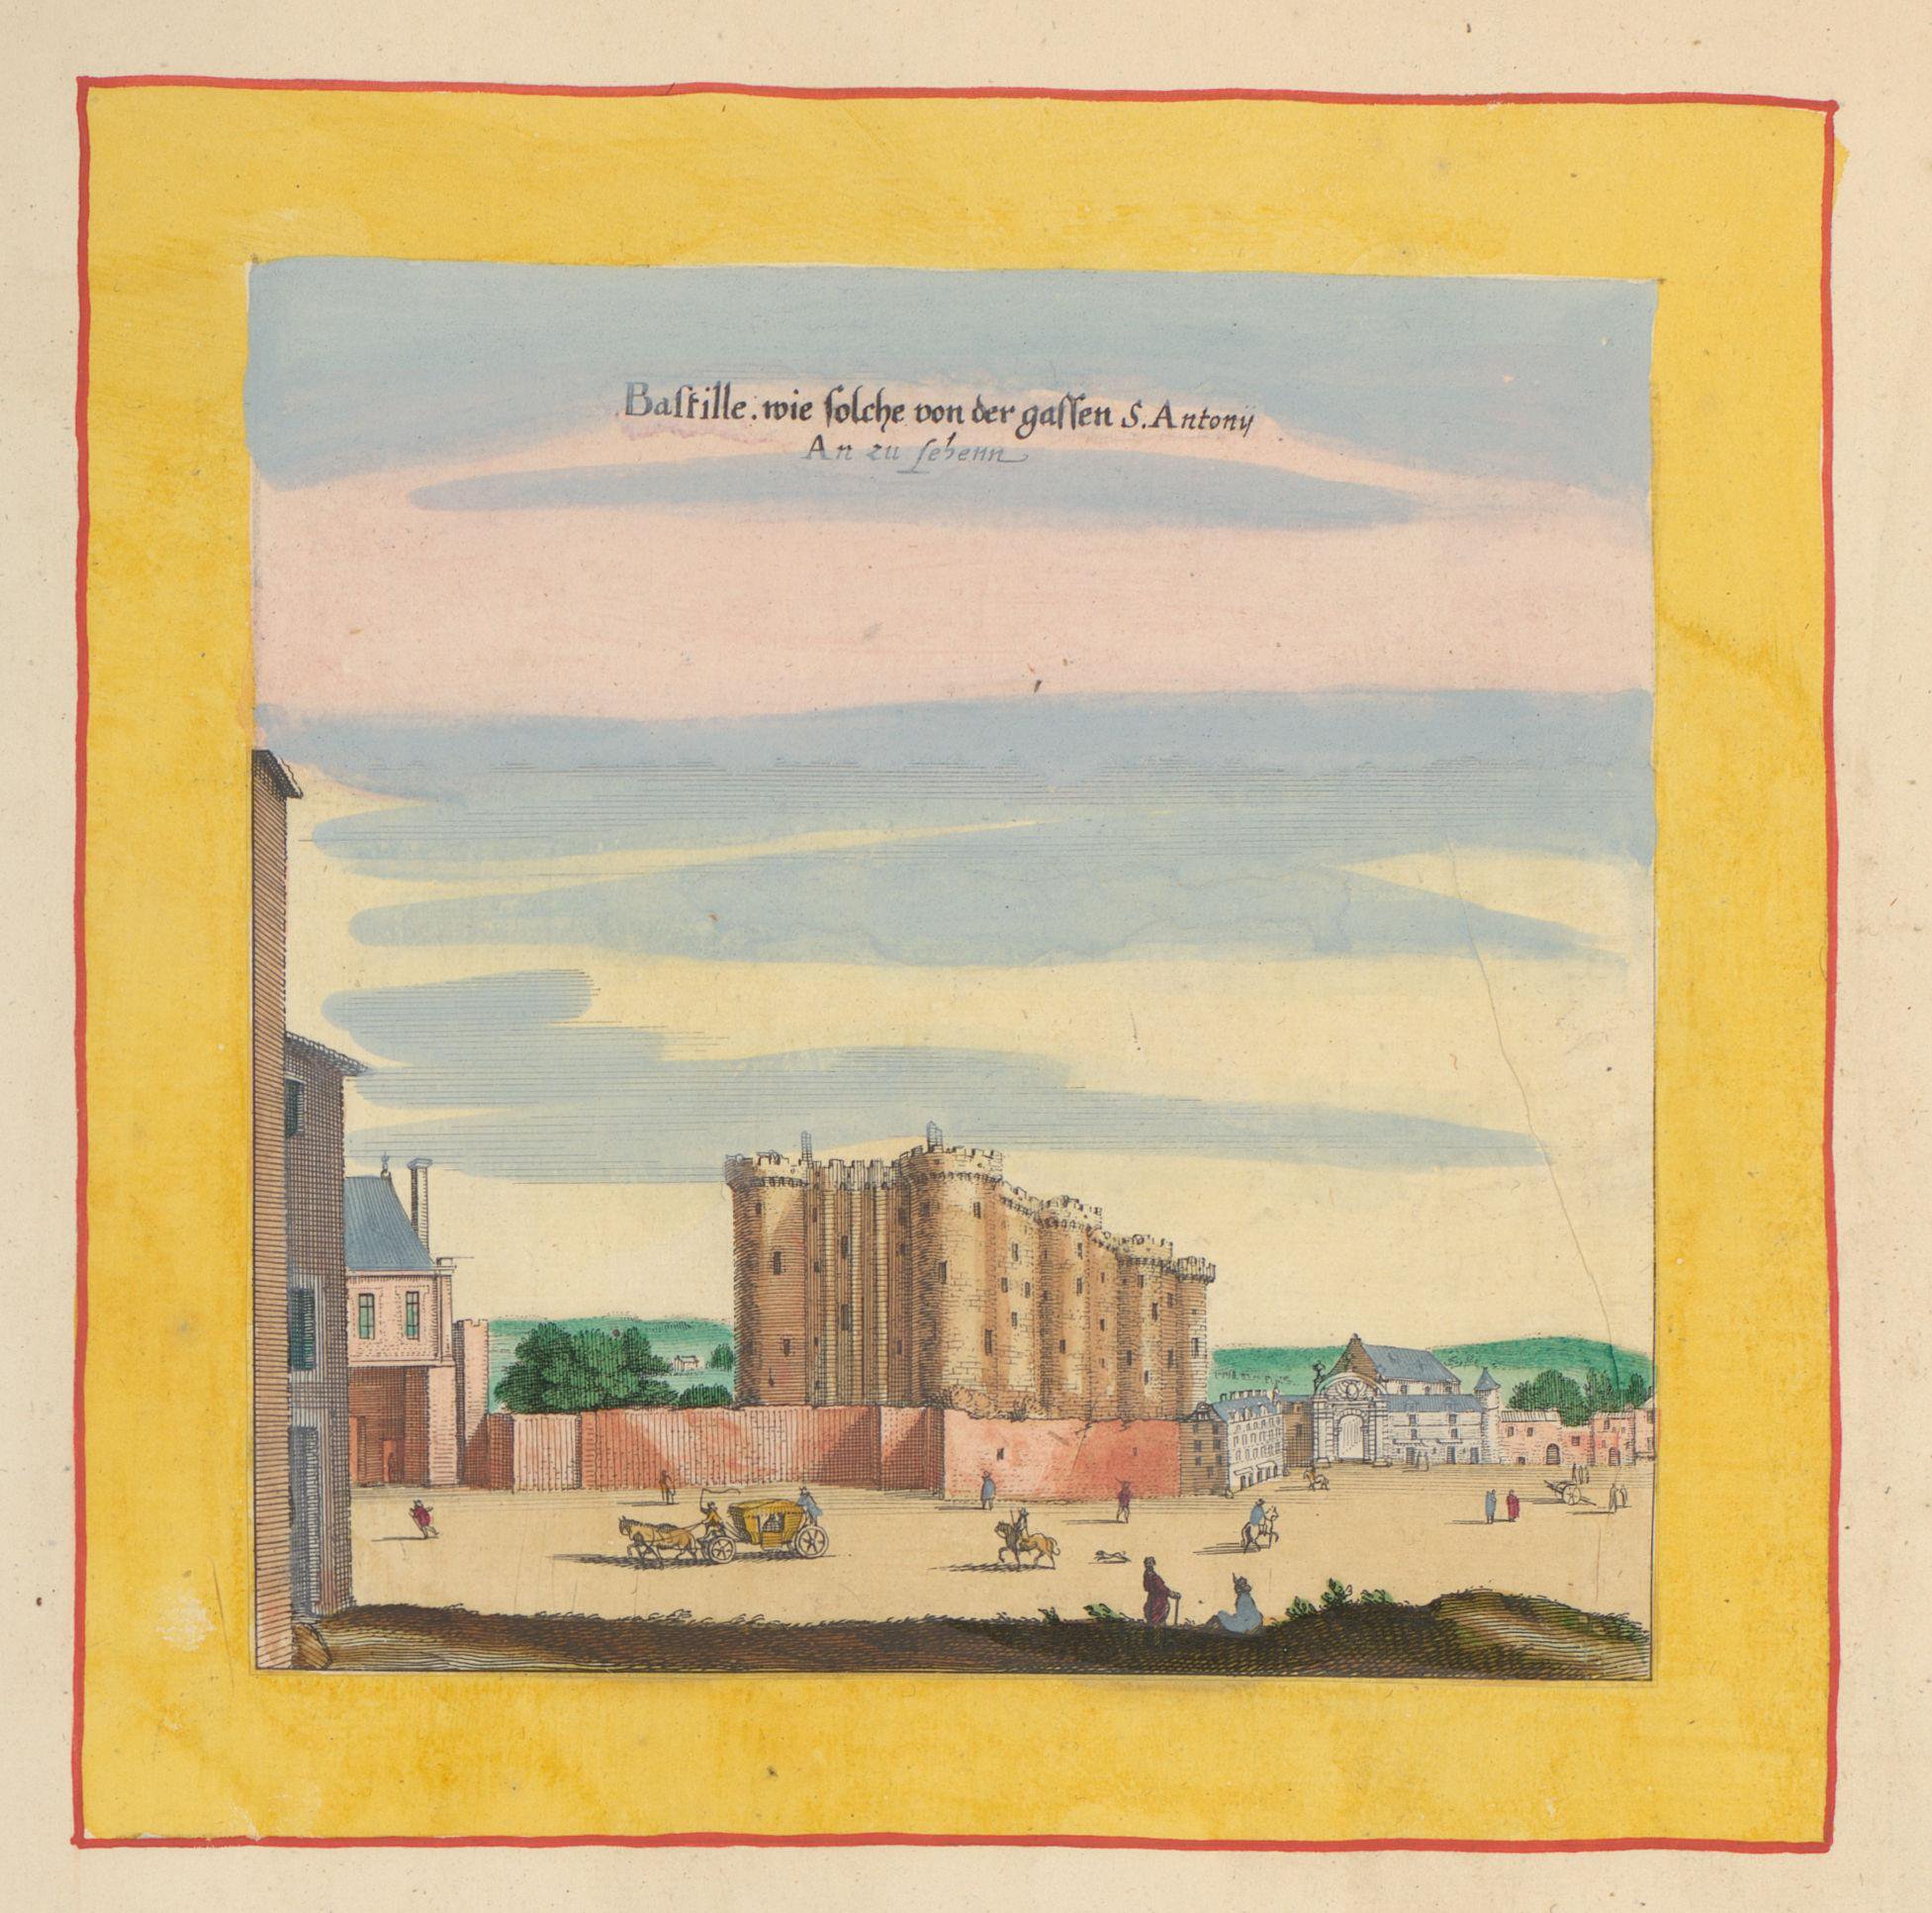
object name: print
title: Gezicht op het fort van de Bastille vanuit de Rue Saint-Antoine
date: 1655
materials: paper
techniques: engraving, etching, hand coloring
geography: frankfurt am main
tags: fortress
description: Prent origineel vervaardigd als boekillustratie voor: Zeiller, Martin. Topographia Galliae, oder Beschreibung und Contrafaitung der vornehmbsten und bekantisten Oerter in dem mächtigen und grossen Königreich Frankreich, 13 delen. Frankfurt am Main: Caspar Merian, 1655-1661. De prent werd voor het eerst gepubliceerd in deel 1: Topographia Galliae, 1655. De prent is langs de bovenrand van de voorstelling afgescheurd. Het bovenste gedeelte is hoger opgeplakt, zodat de lucht hoger is geworden en het formaat van de voorstelling past bij de andere groot formaatvoorstellingen in het album. De voorstelling is aan de bovenzijde aangevuld met een geschilderde lucht.